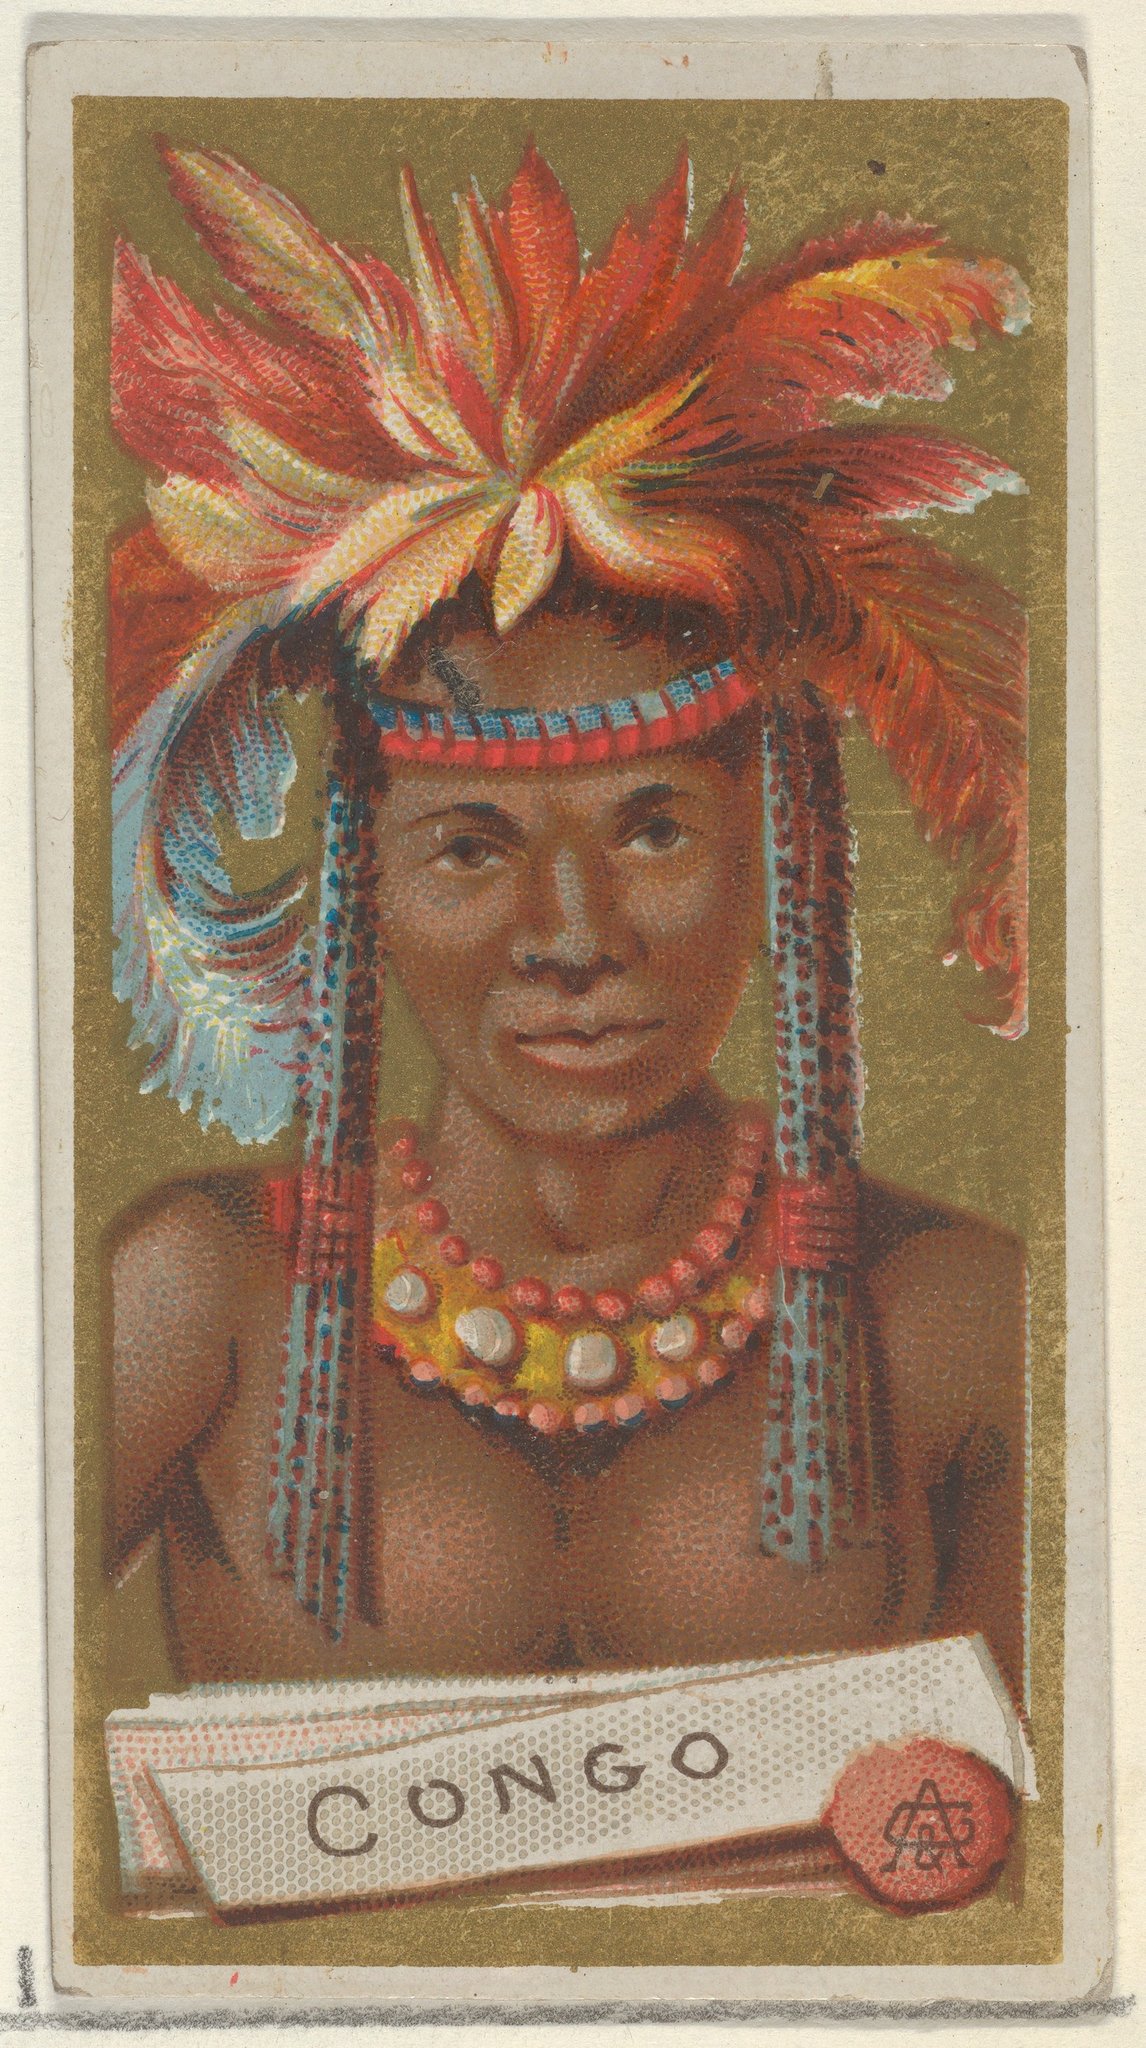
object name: print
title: Congo, from the Types of All Nations series (N24) for Allen & Ginter Cigarettes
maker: allen & ginter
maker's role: publisher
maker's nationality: american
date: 1889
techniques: color lithograph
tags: men